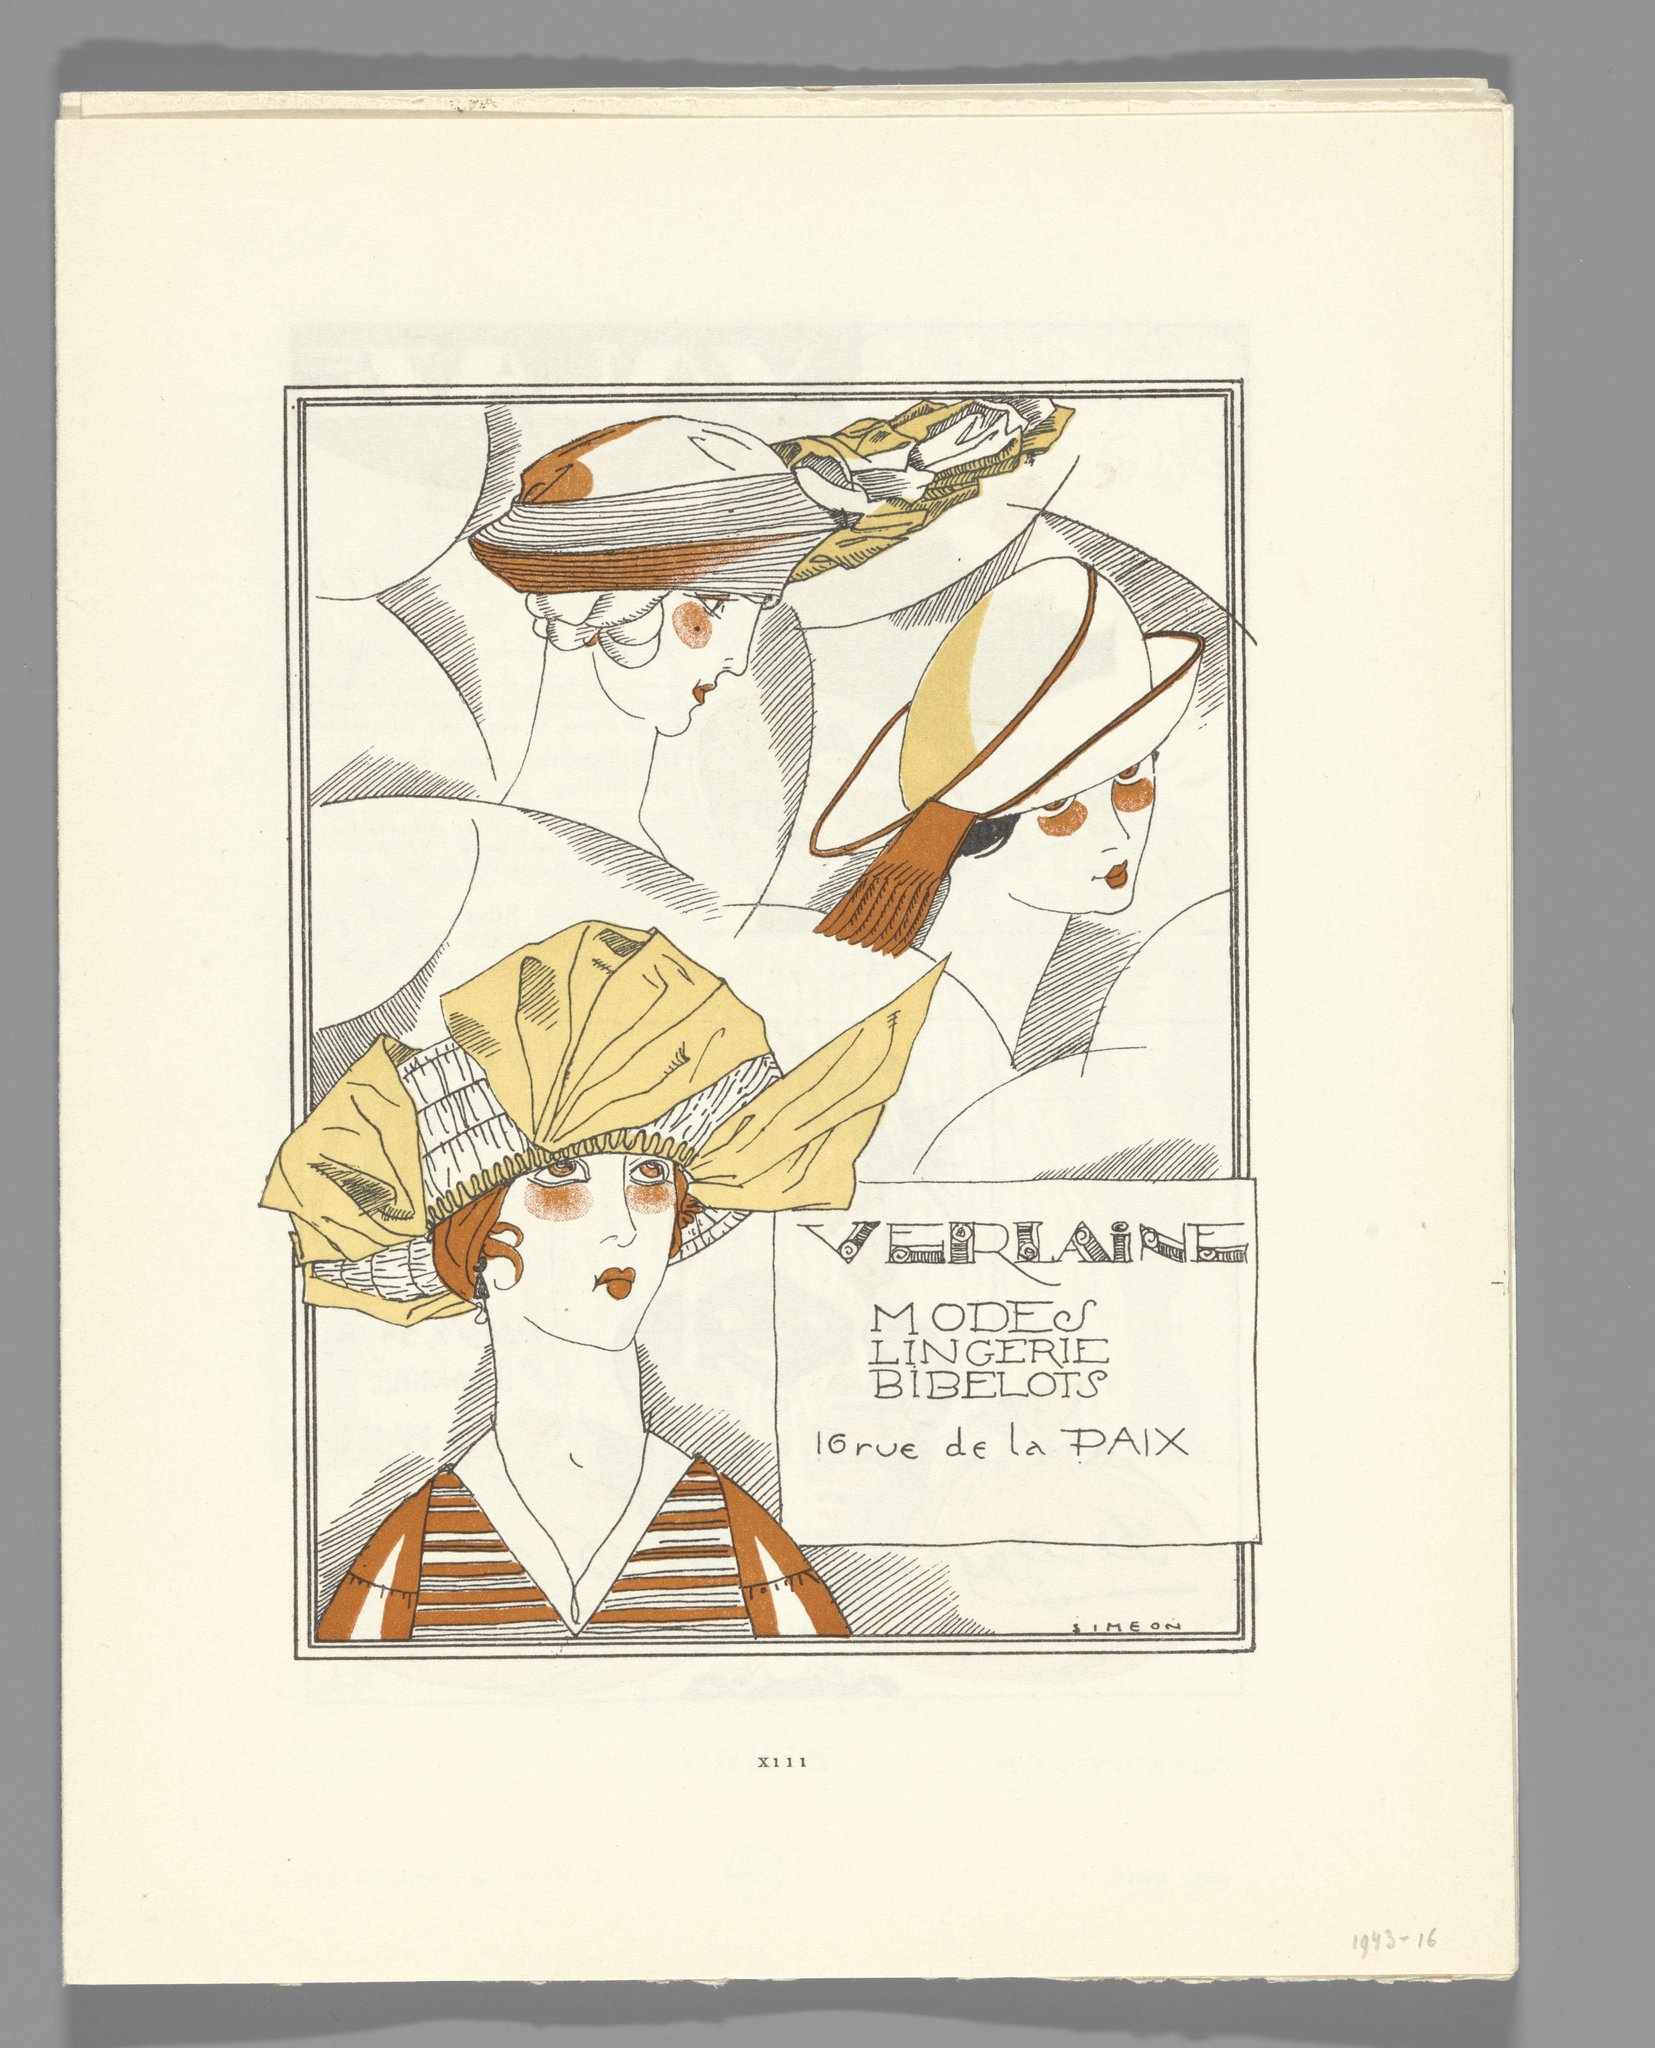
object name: fashion print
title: Gazette du Bon Ton, 1920 - No. 2, p. XIII: advertentie hoeden van Verlaine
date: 1920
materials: paper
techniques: lithograph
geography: paris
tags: head-gear: toque (+ women's clothes), fashion plates, head-gear: hat (+ women's clothes)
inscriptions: date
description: Drie verschillende dameshoeden. Advertentie van Verlaine, Modes, Lingerie, Bibelots, 16, rue de la Paix.